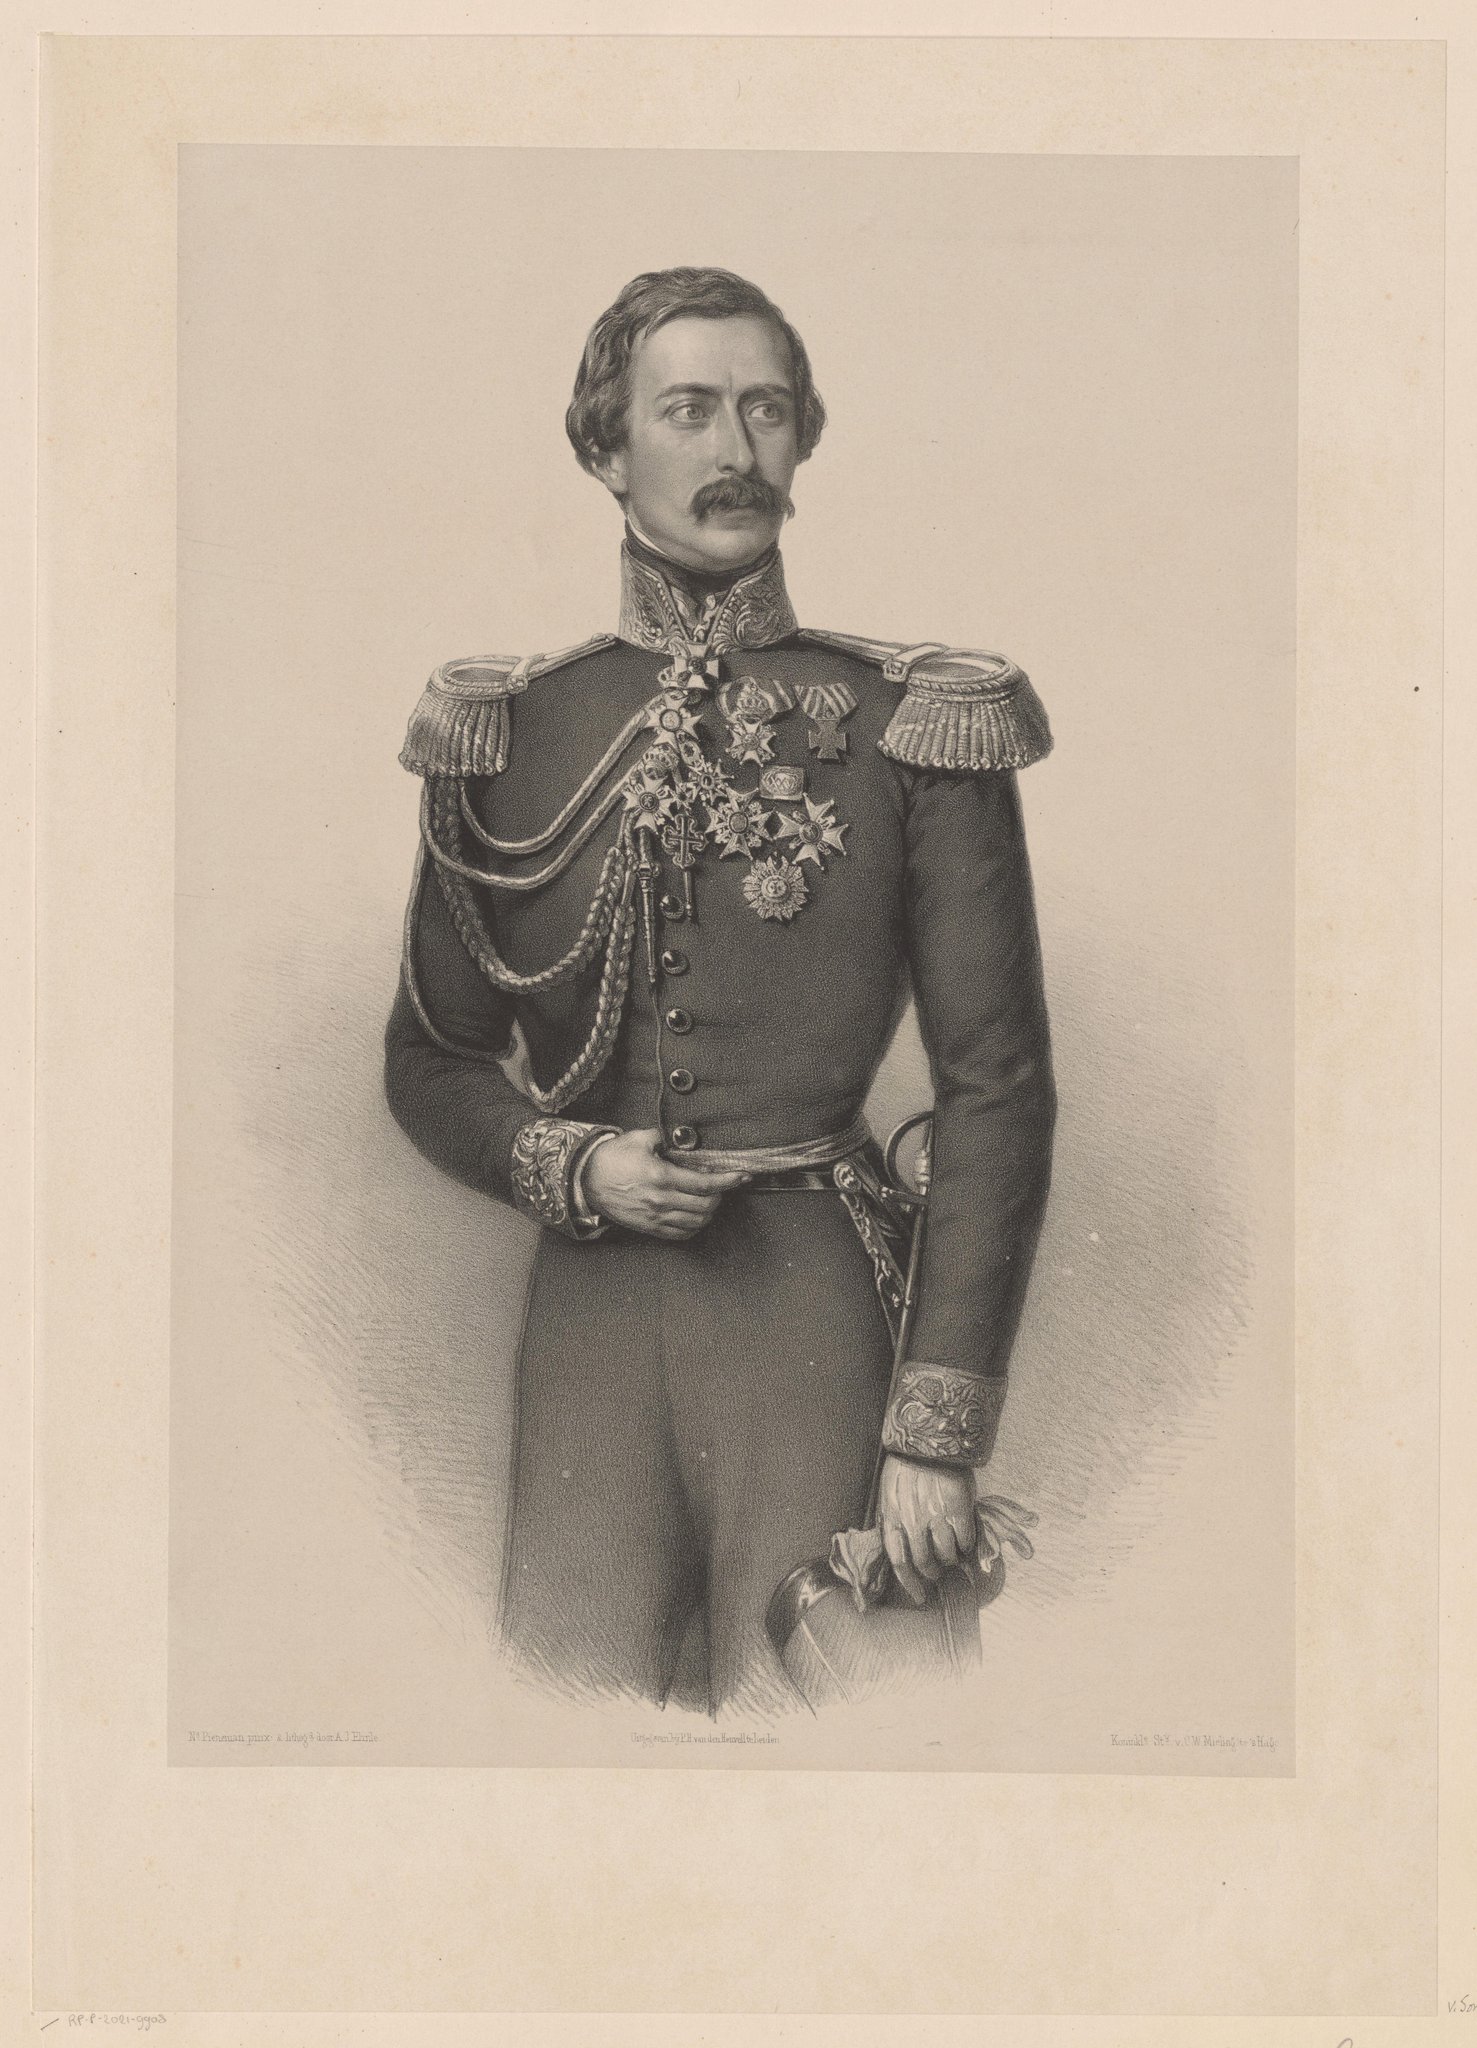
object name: print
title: Portret van Eduard August Otto de Casembroot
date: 1847-1862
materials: paper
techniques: lithograph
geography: leiden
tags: eduard august otto de casembroot, historical persons, medals and other marks of military honour